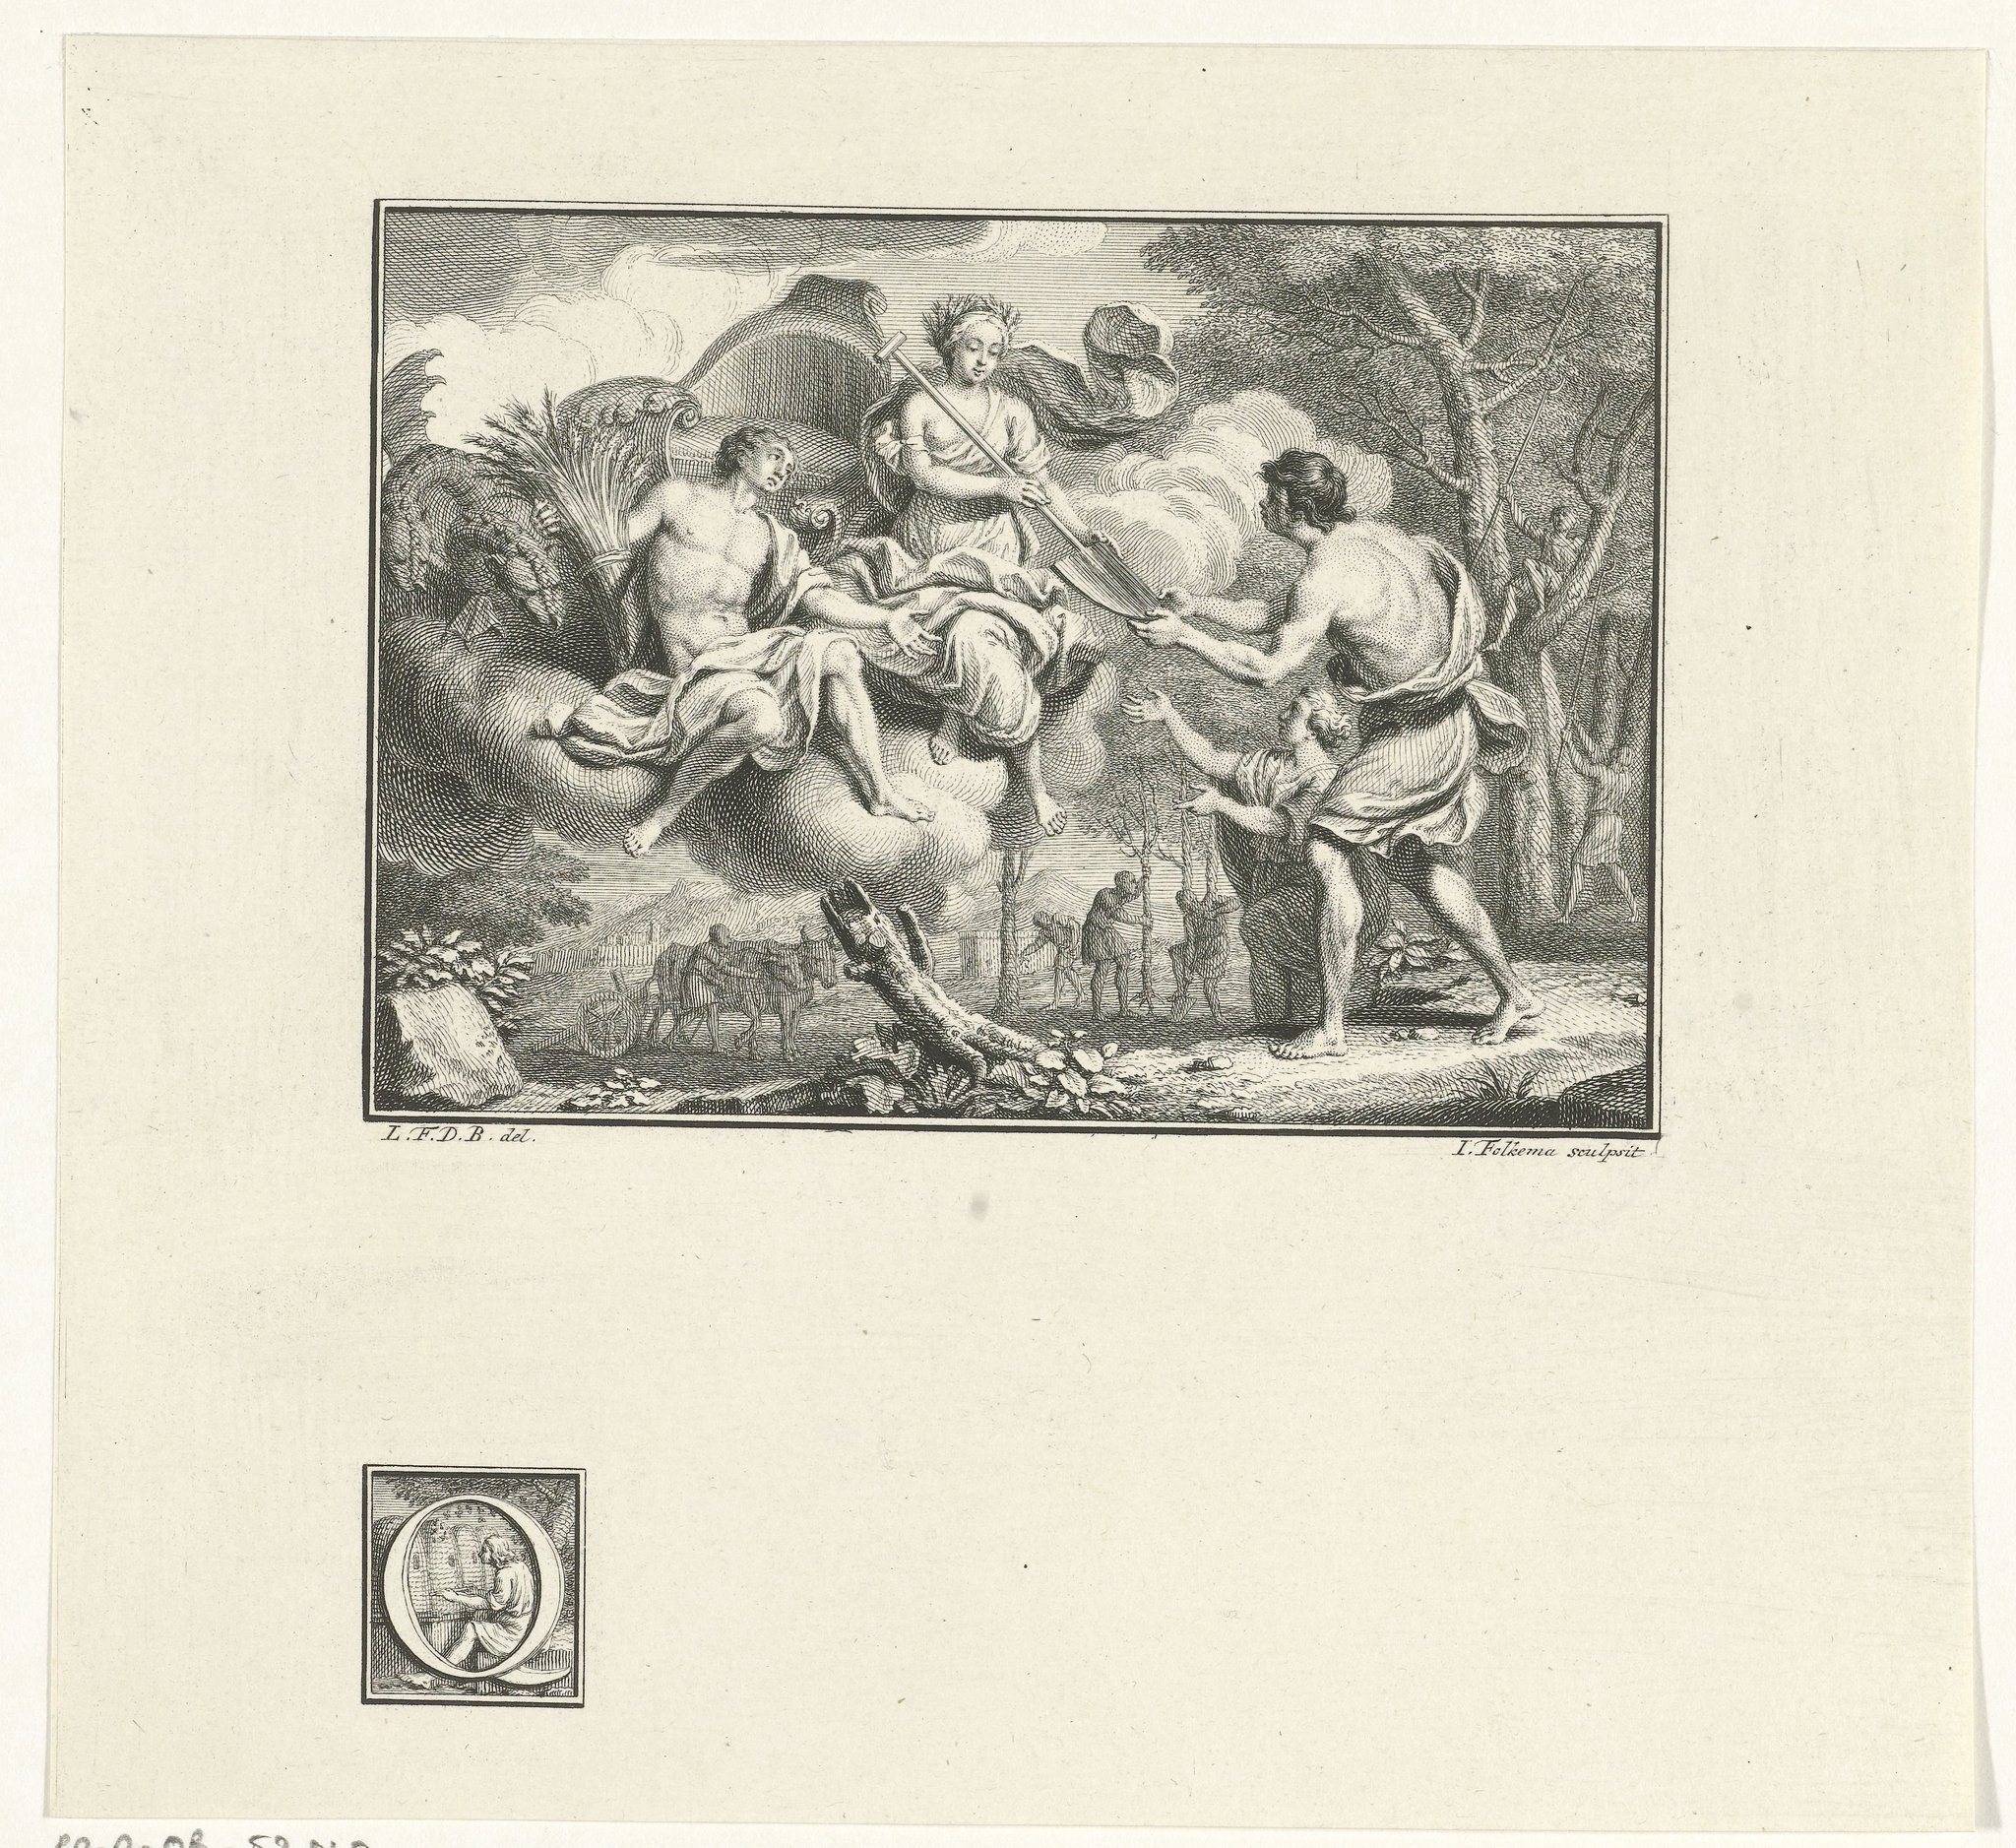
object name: print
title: Voorstellingen uit Vergilius' Bucolia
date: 1703-1767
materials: paper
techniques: etching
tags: (story of) ceres (demeter)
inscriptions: collector's mark: Lugt 240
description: Ceres, godin van de landbouw, verschijnt op het platteland waar ze een boer en boerin een schep overhandigt. Zij wordt vergezeld door een allegorische figuur met een korenschoof in zijn armen. Achter dit tweetal zweeft de door draken voortgetrokken wagen van Ceres in de lucht. Op dezelfde plaat staat links onder deze voorstelling een versierd initaal O met de beeltenis van een figuur gezeten bij vier bijenkorven. Deze illustratie is vervaardigd bij een verhaal uit Vergilius' Bucolica.